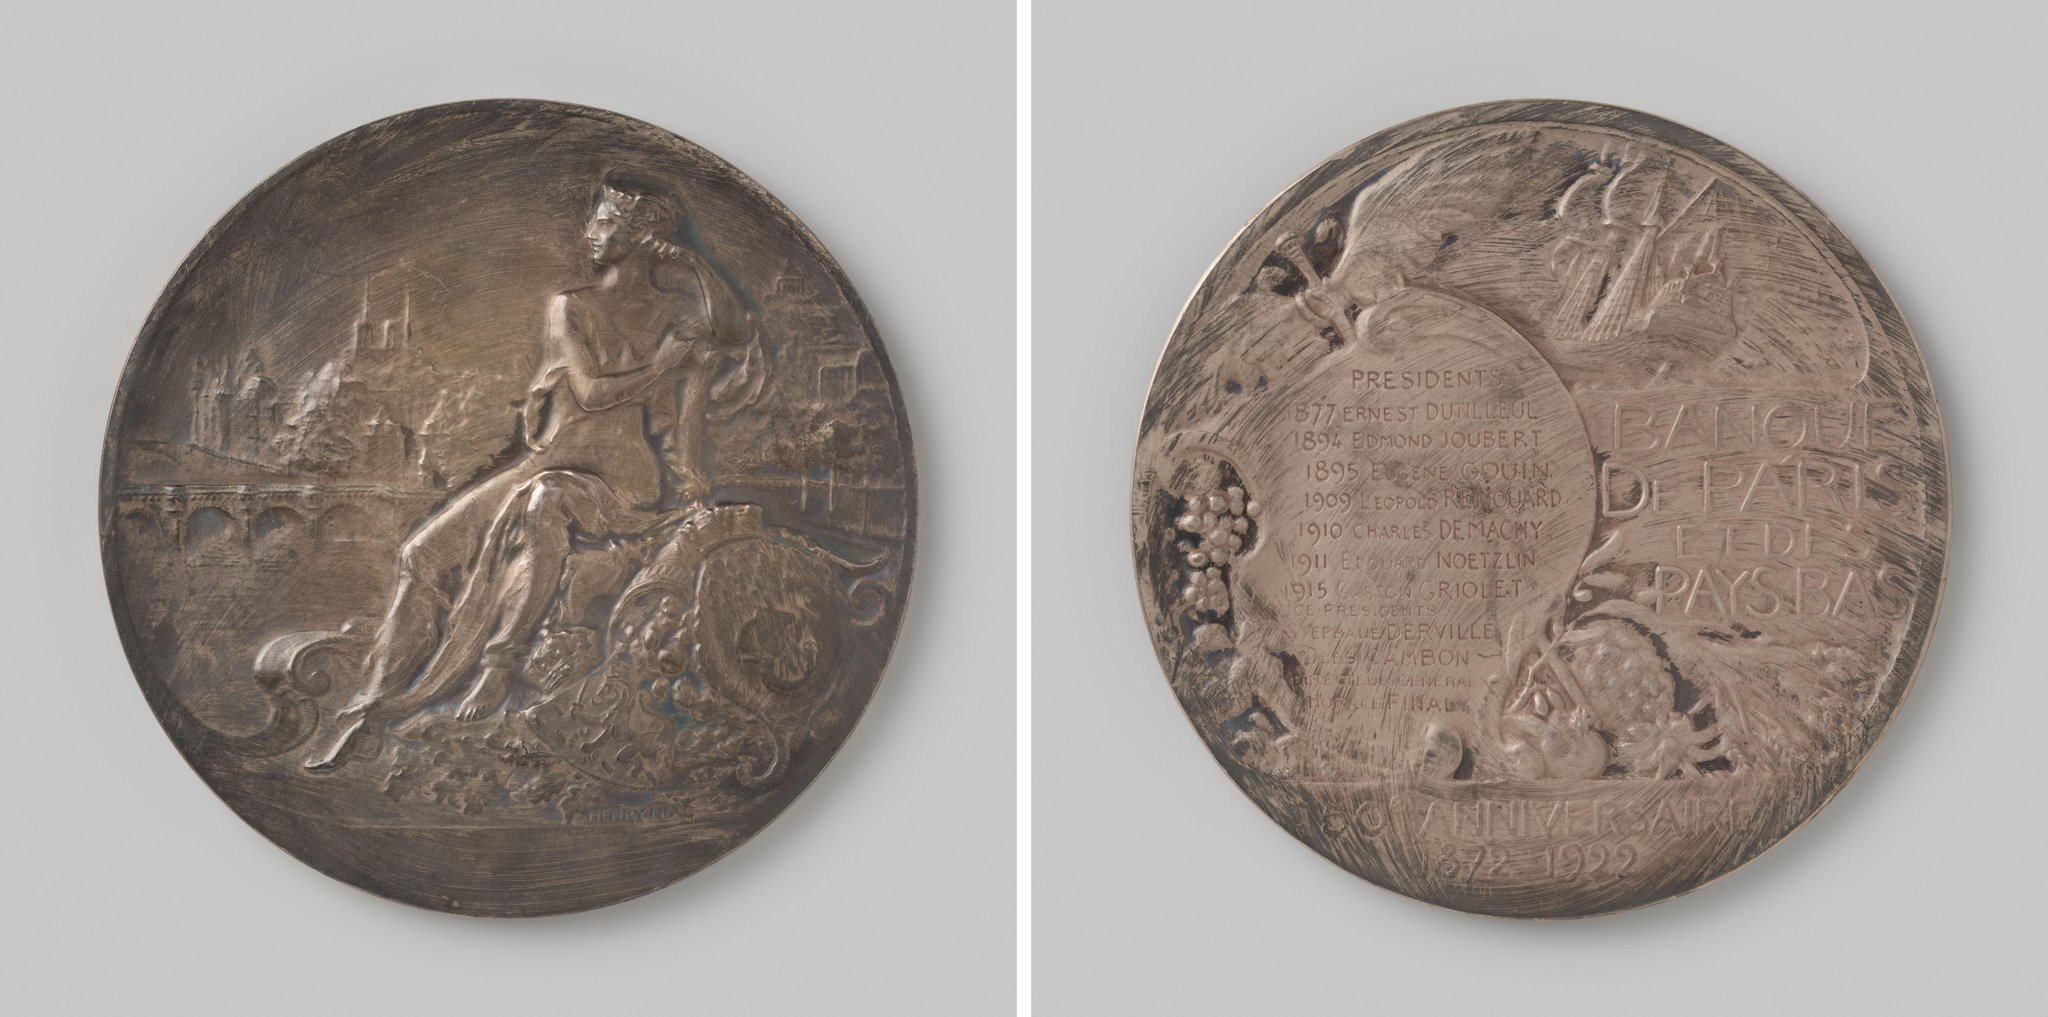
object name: history medal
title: Vijftigjarig bestaan van de Banque de Paris et des Pays-Bas 1922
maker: henri nocq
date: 1922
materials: silver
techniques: striking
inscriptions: hallmark: ‘ARGENT (tussen twee tekens)’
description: Zilveren penning, op de voorzijde een zittende vrouw met een hoorn des overvloeds waartegen de gekroonde wapenschilden van Nederand en Parijs, op de achtergrond een gezicht op Parijs, op de keerzijde vier regels tekst met links een cartouche met opschrift waarachter een mercuriusstaf, motieven uit land- en tuinbouw en een driemaster op zee, met afsnedetekst.